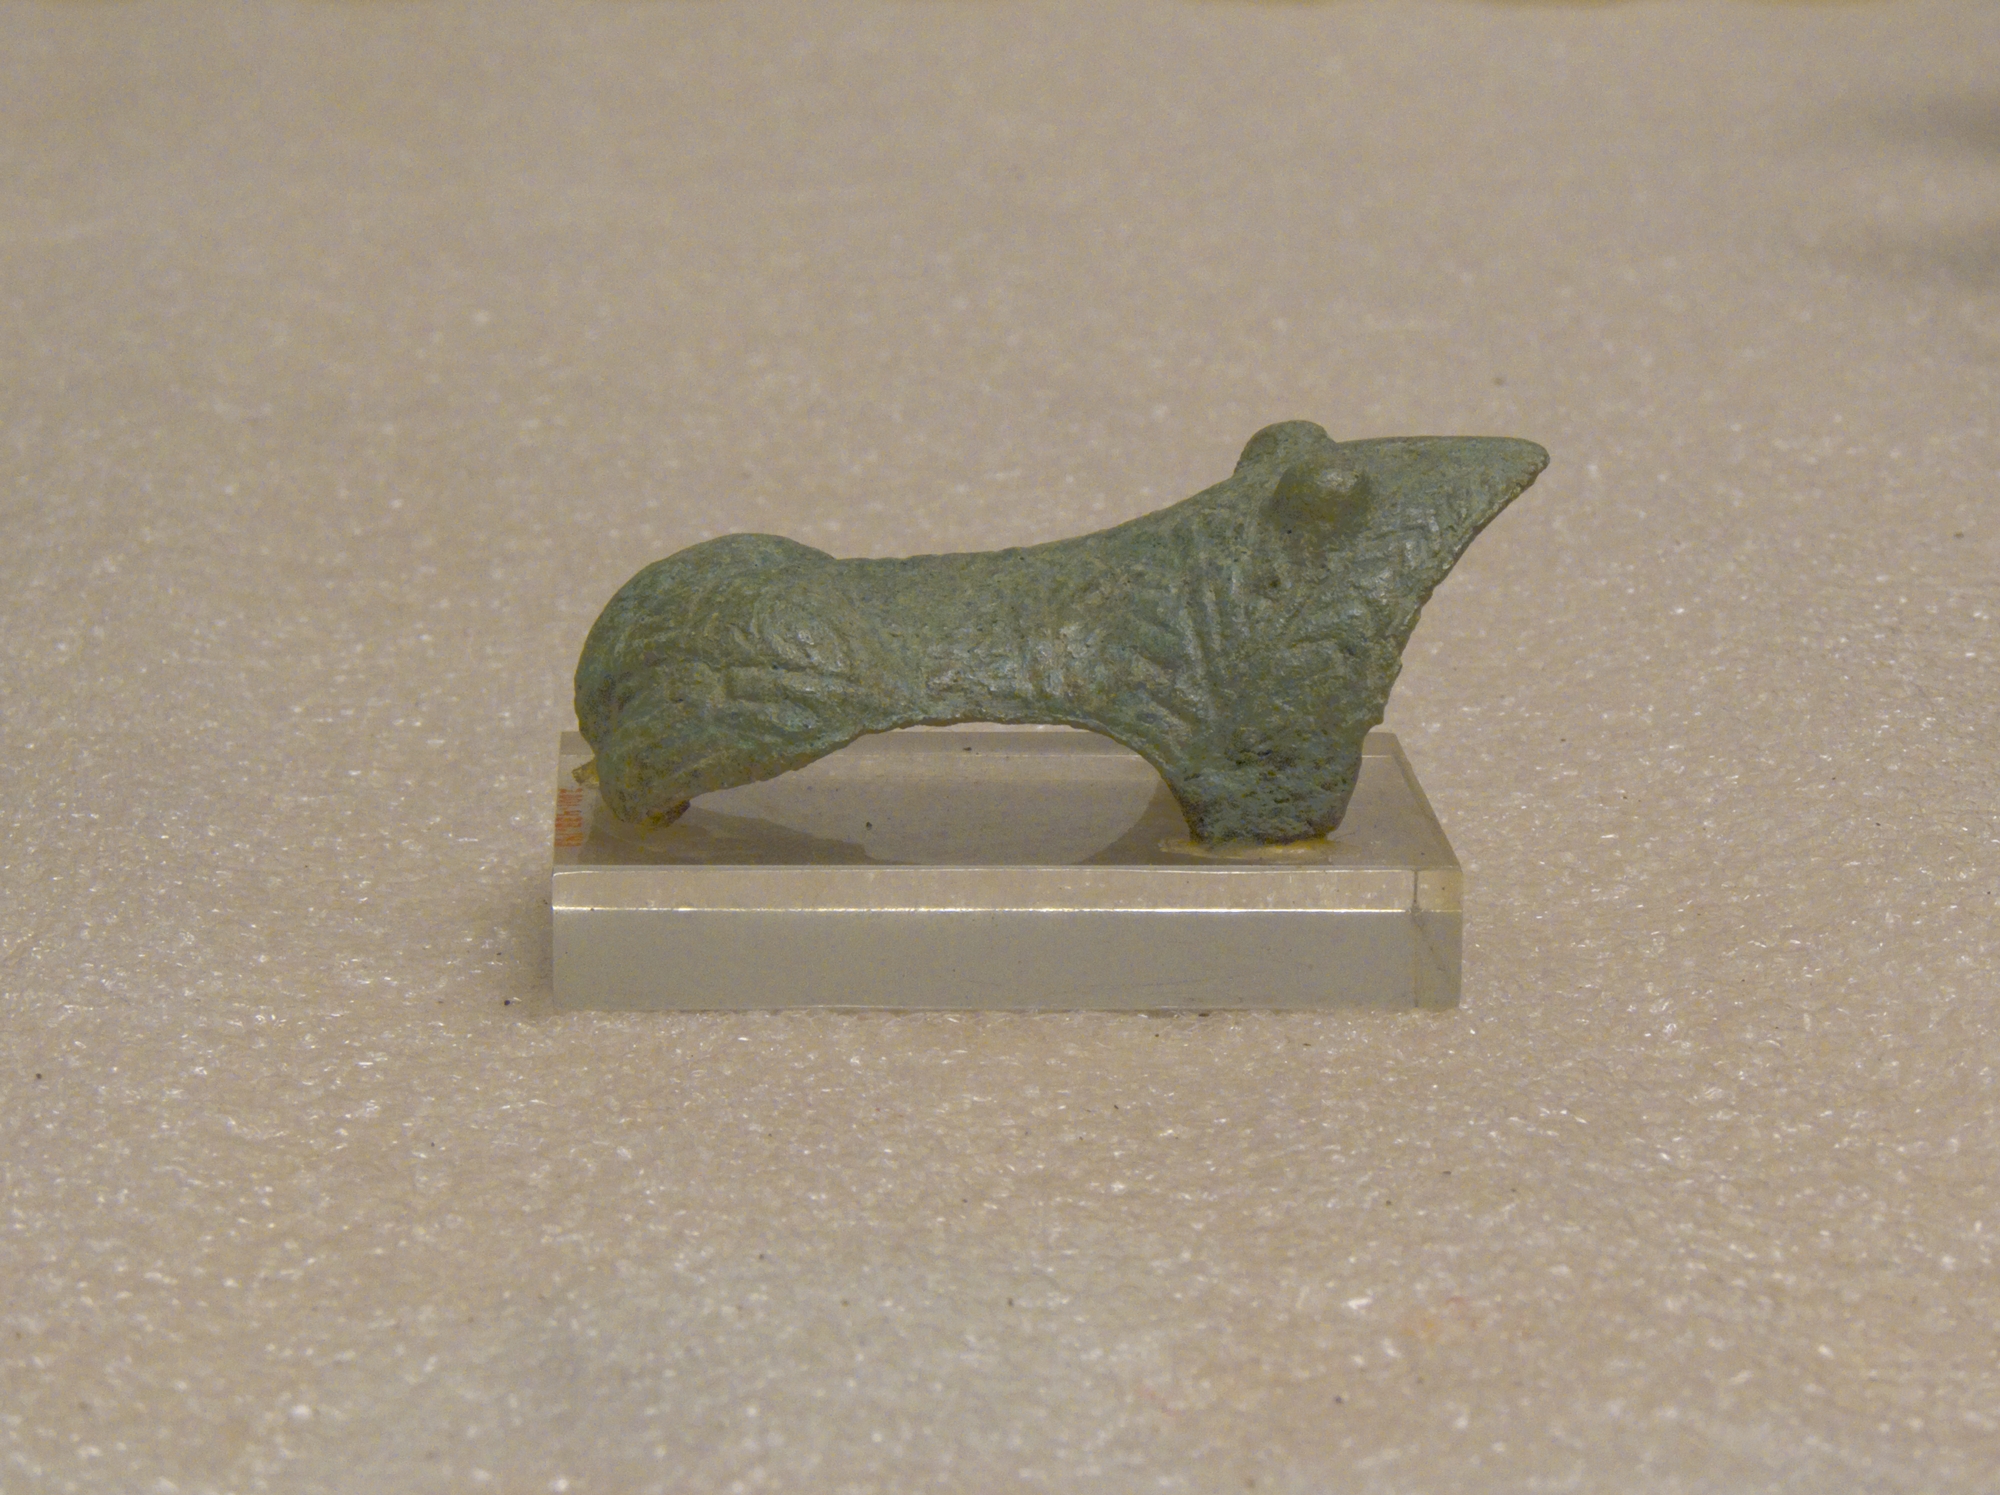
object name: drum ornament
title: Frog from a Drum (?)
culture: thai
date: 500 BCE-300 CE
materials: bronze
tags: frogs